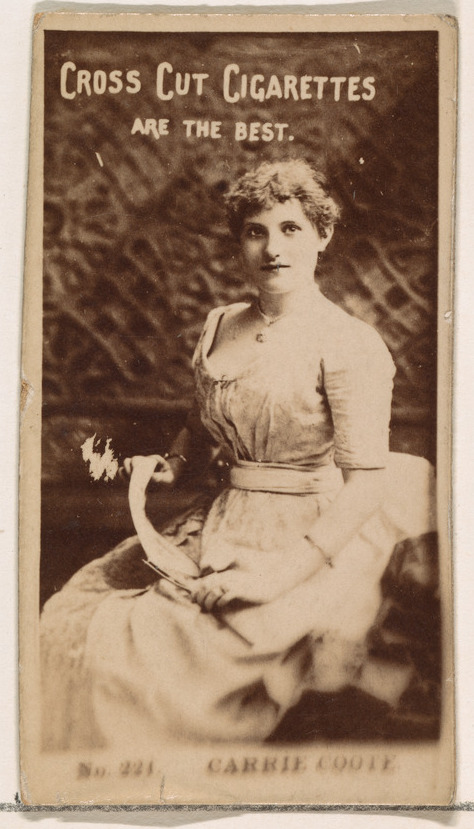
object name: print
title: Card Number 221, Carrie Coote, from the Actors and Actresses series (N145-2) issued by Duke Sons & Co. to promote Cross Cut Cigarettes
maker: w. duke, sons & co.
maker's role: publisher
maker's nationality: american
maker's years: 1870-1920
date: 1880-1889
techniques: albumen silver print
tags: portraits,women,actresses